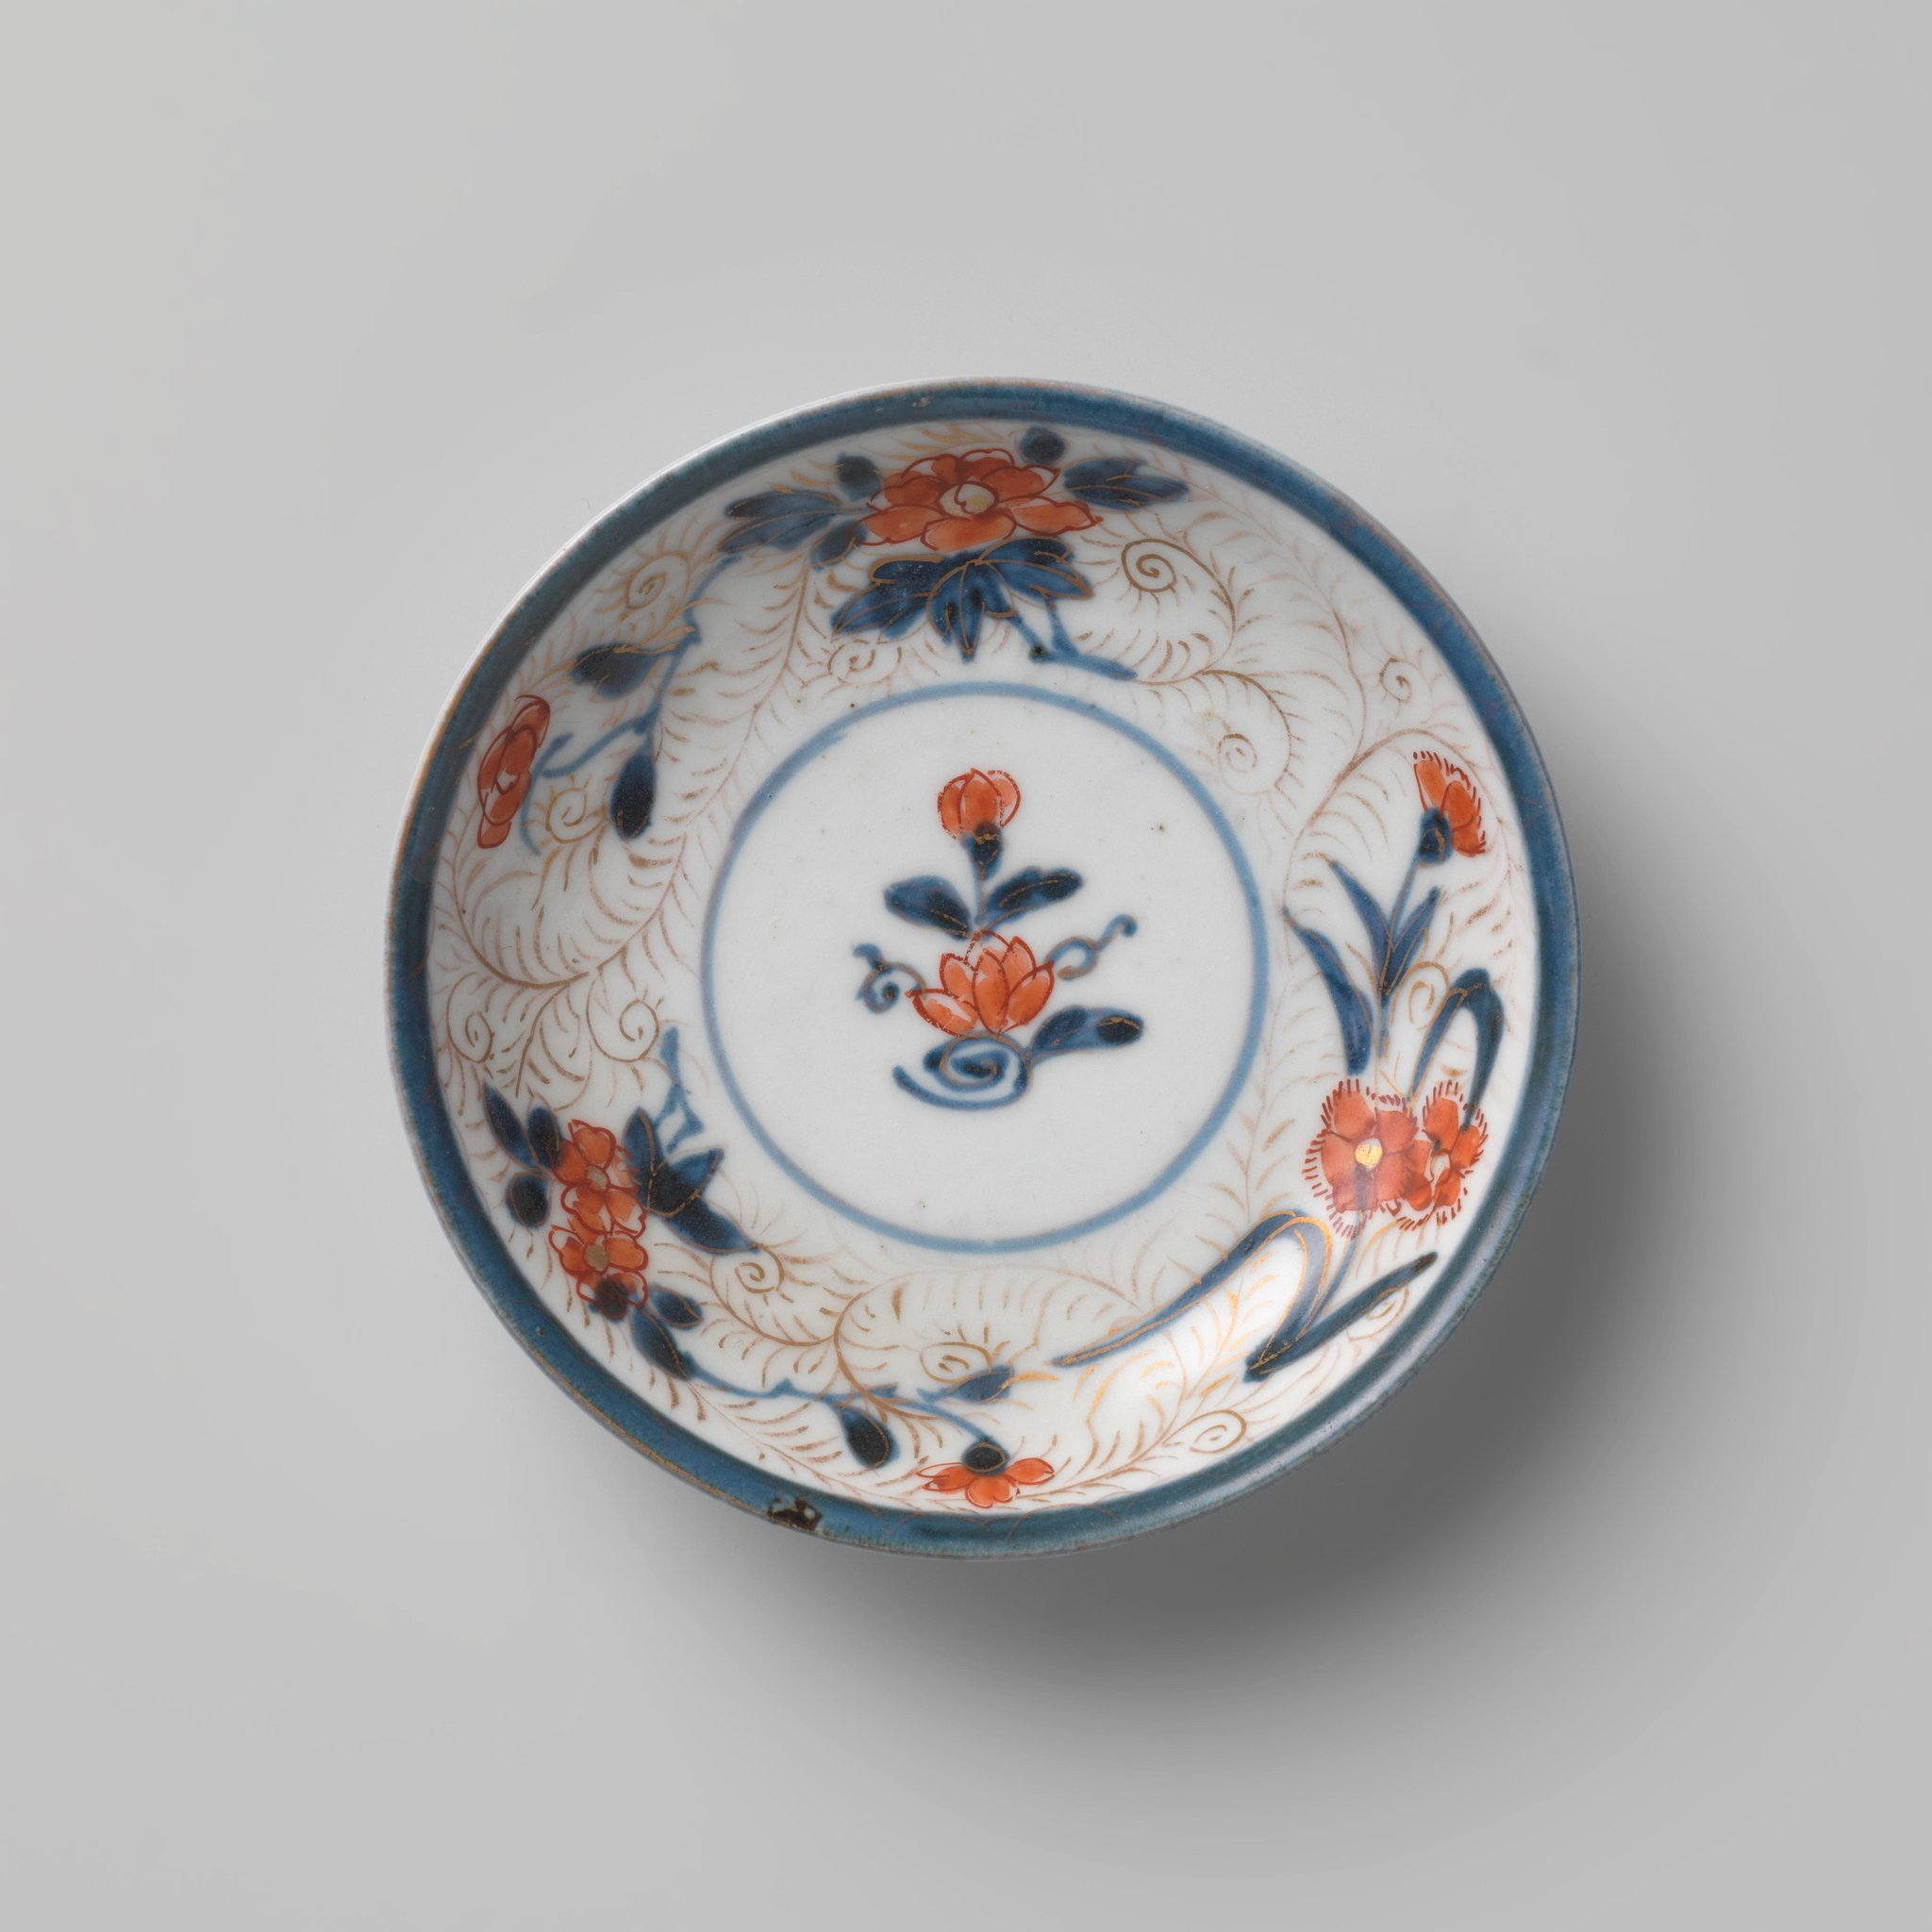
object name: kop en schotel, kop en schotel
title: Saucer with flower sprays and foliate scrolls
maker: Anonymous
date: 1800-1815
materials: cobalt, glaze, gold, paint, porcelain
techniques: firing, gilding, turning, vitrification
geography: japan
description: Schotel van porselein, beschilderd in onderglazuur blauw en op het glazuur rood en goud. Op het plat van de schotel een lotusrank in een medaillon. Om het medaillon bladranken met daartussen drie bloemtakken. De binnenrand is blauw. Imari.